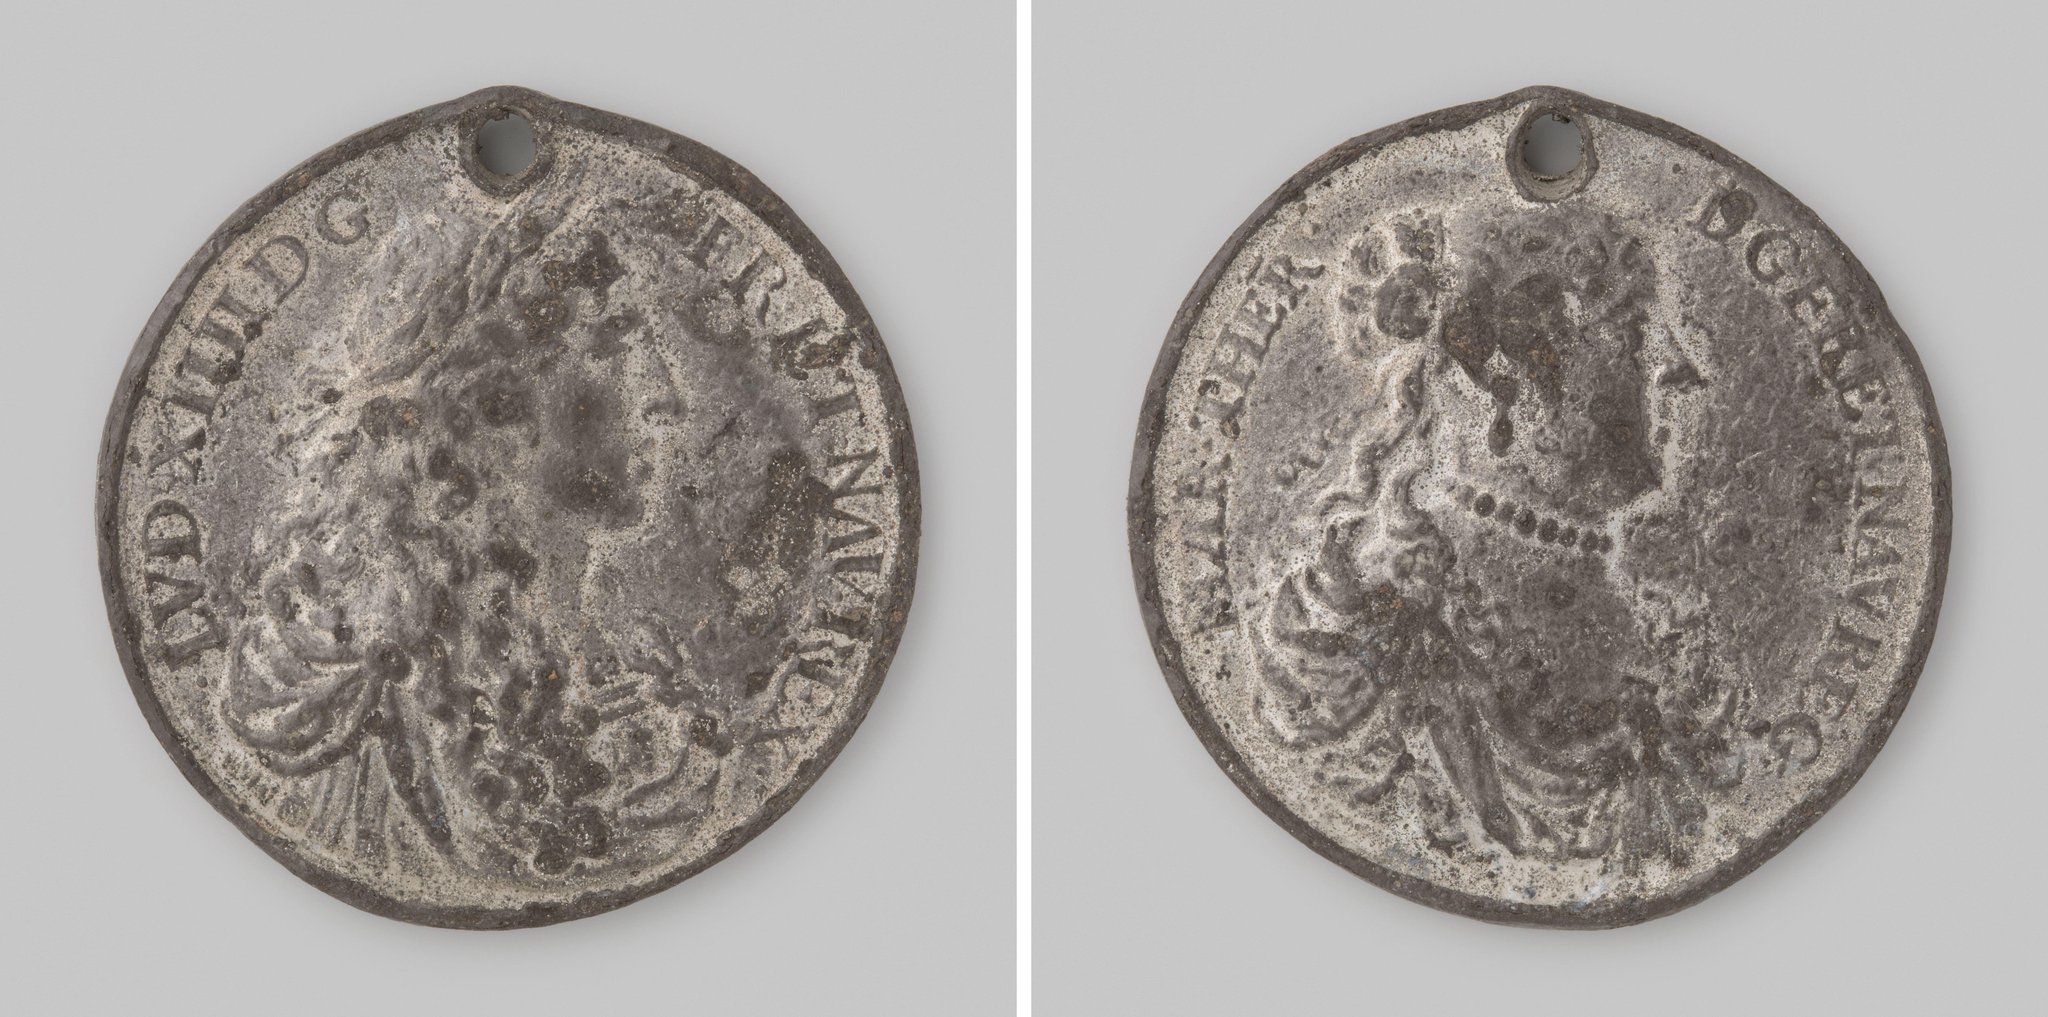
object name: history medal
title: Huwelijk van Koning Lodewijk XIV van Frankrijk met Maria Theresia van Spanje 1660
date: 1660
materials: tin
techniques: casting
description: Tinnen gegoten penning met draaggat, op de voorzijde het borstbeeld van Lodewijk XIIII naar rechts met omschrift, op de keerzijde het borstbeeld van Maria Theresia naar rechts met omschrift.